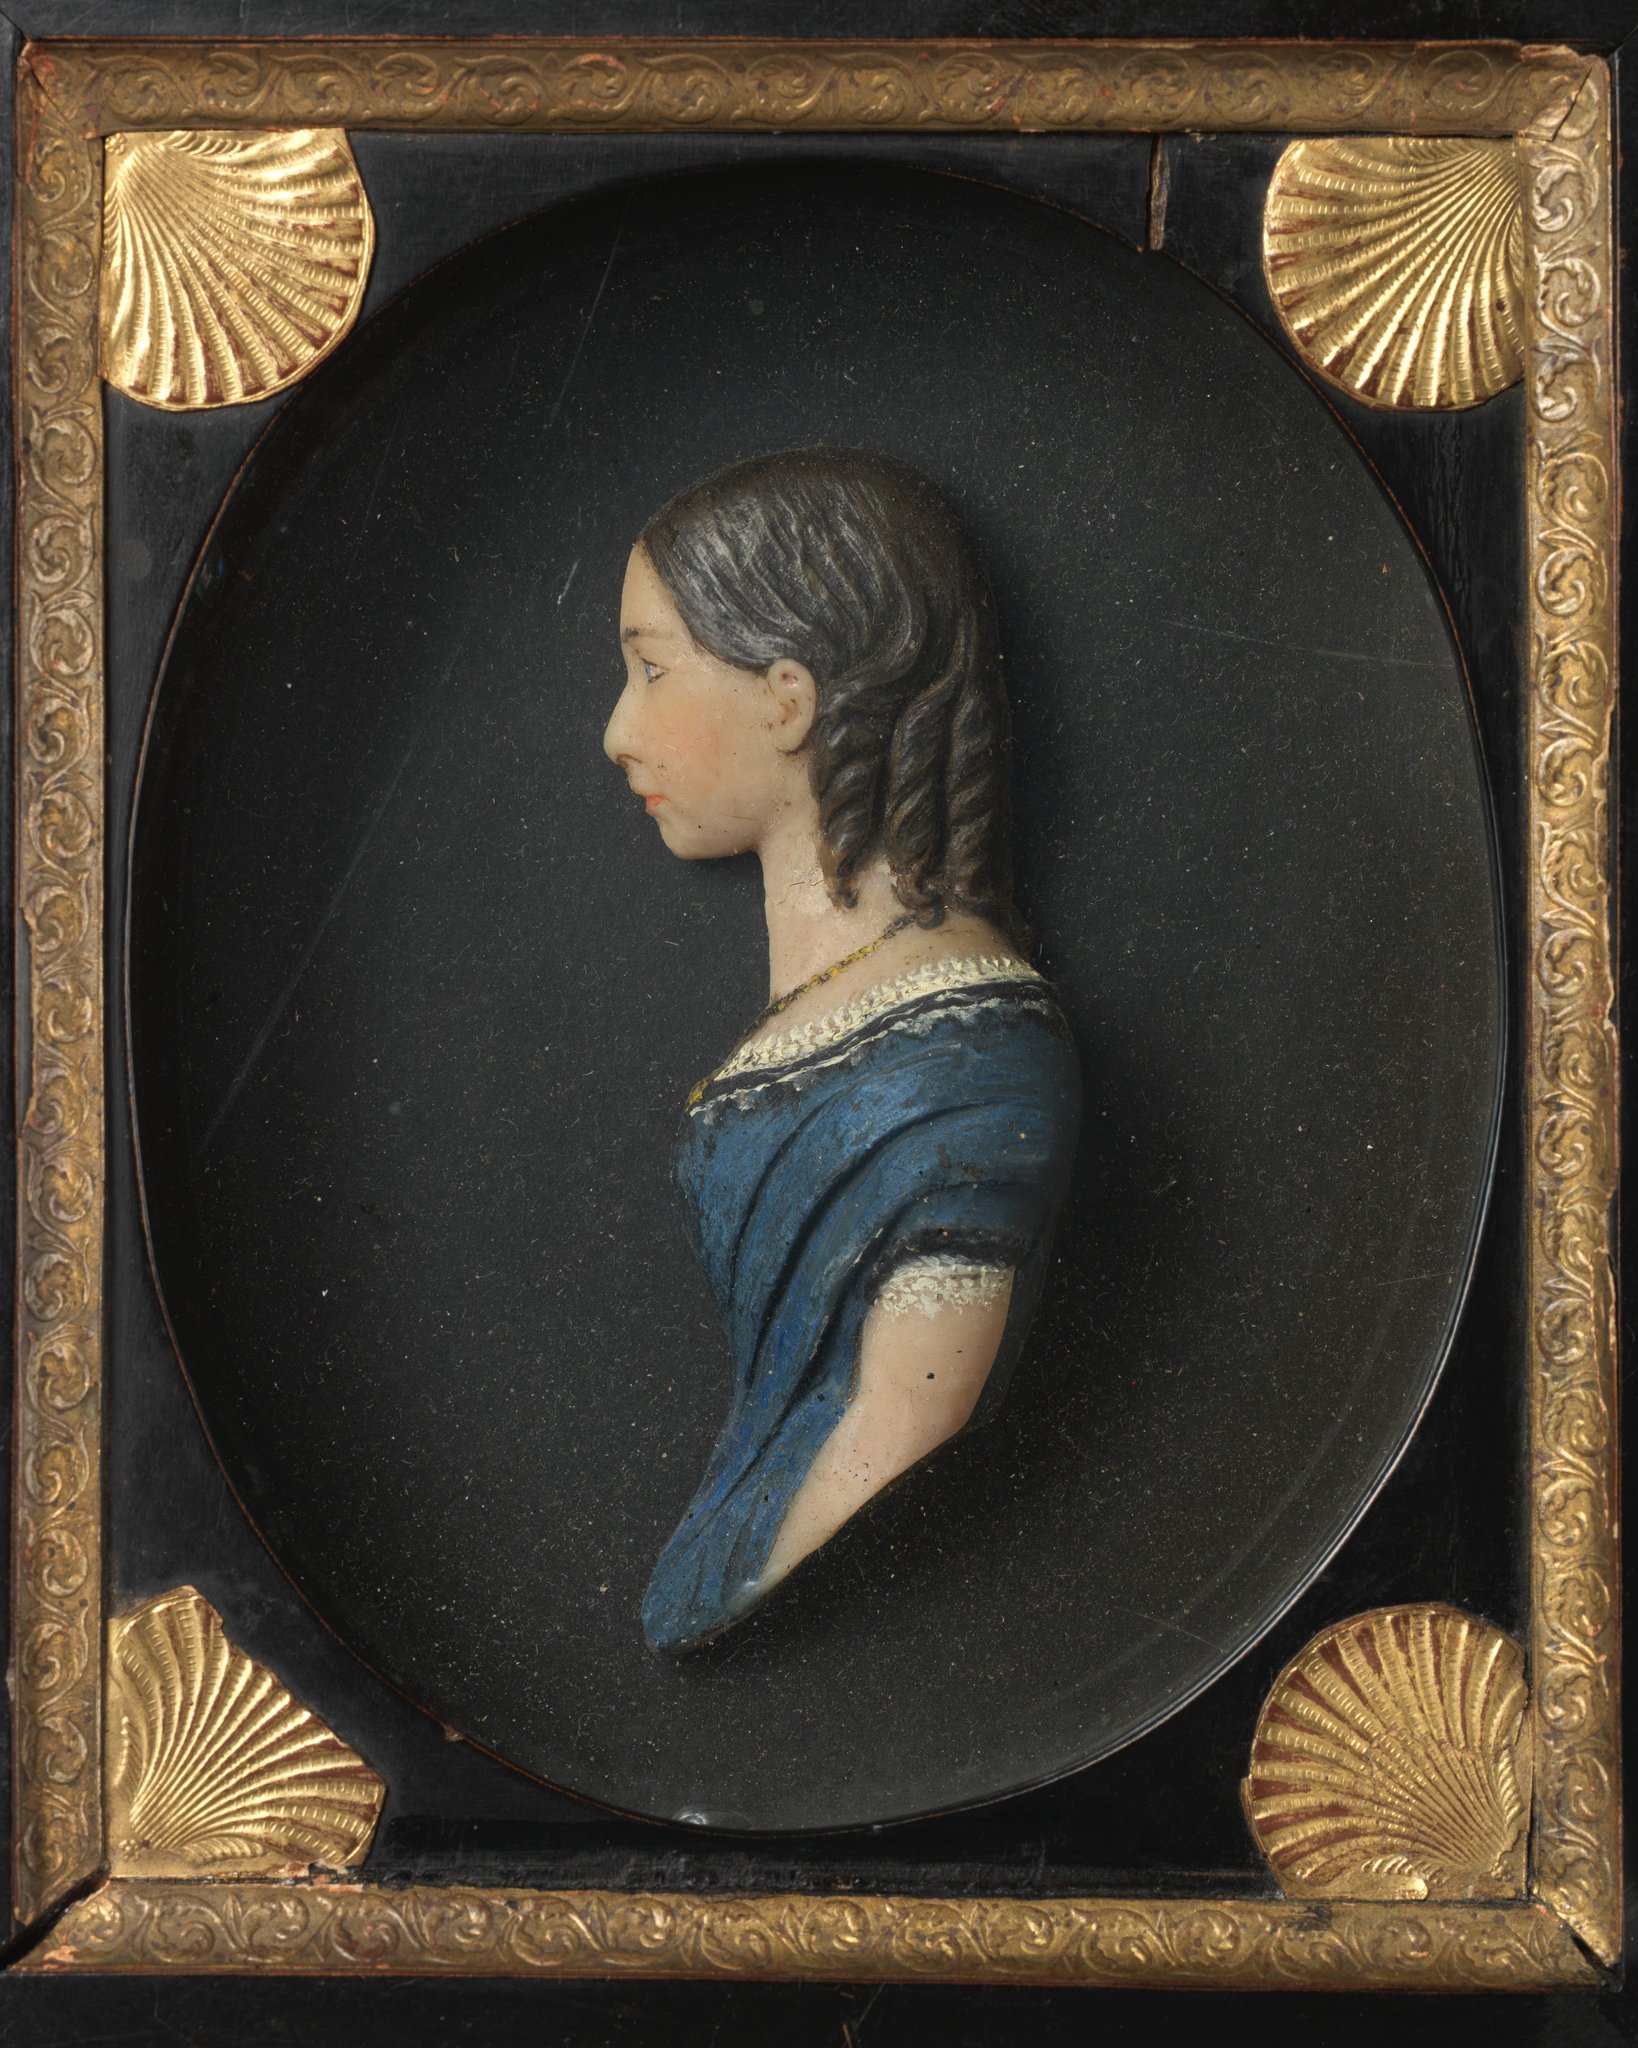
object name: relief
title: Portrait of a girl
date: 1801-1900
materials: gilt, wax, wood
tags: girls,profiles